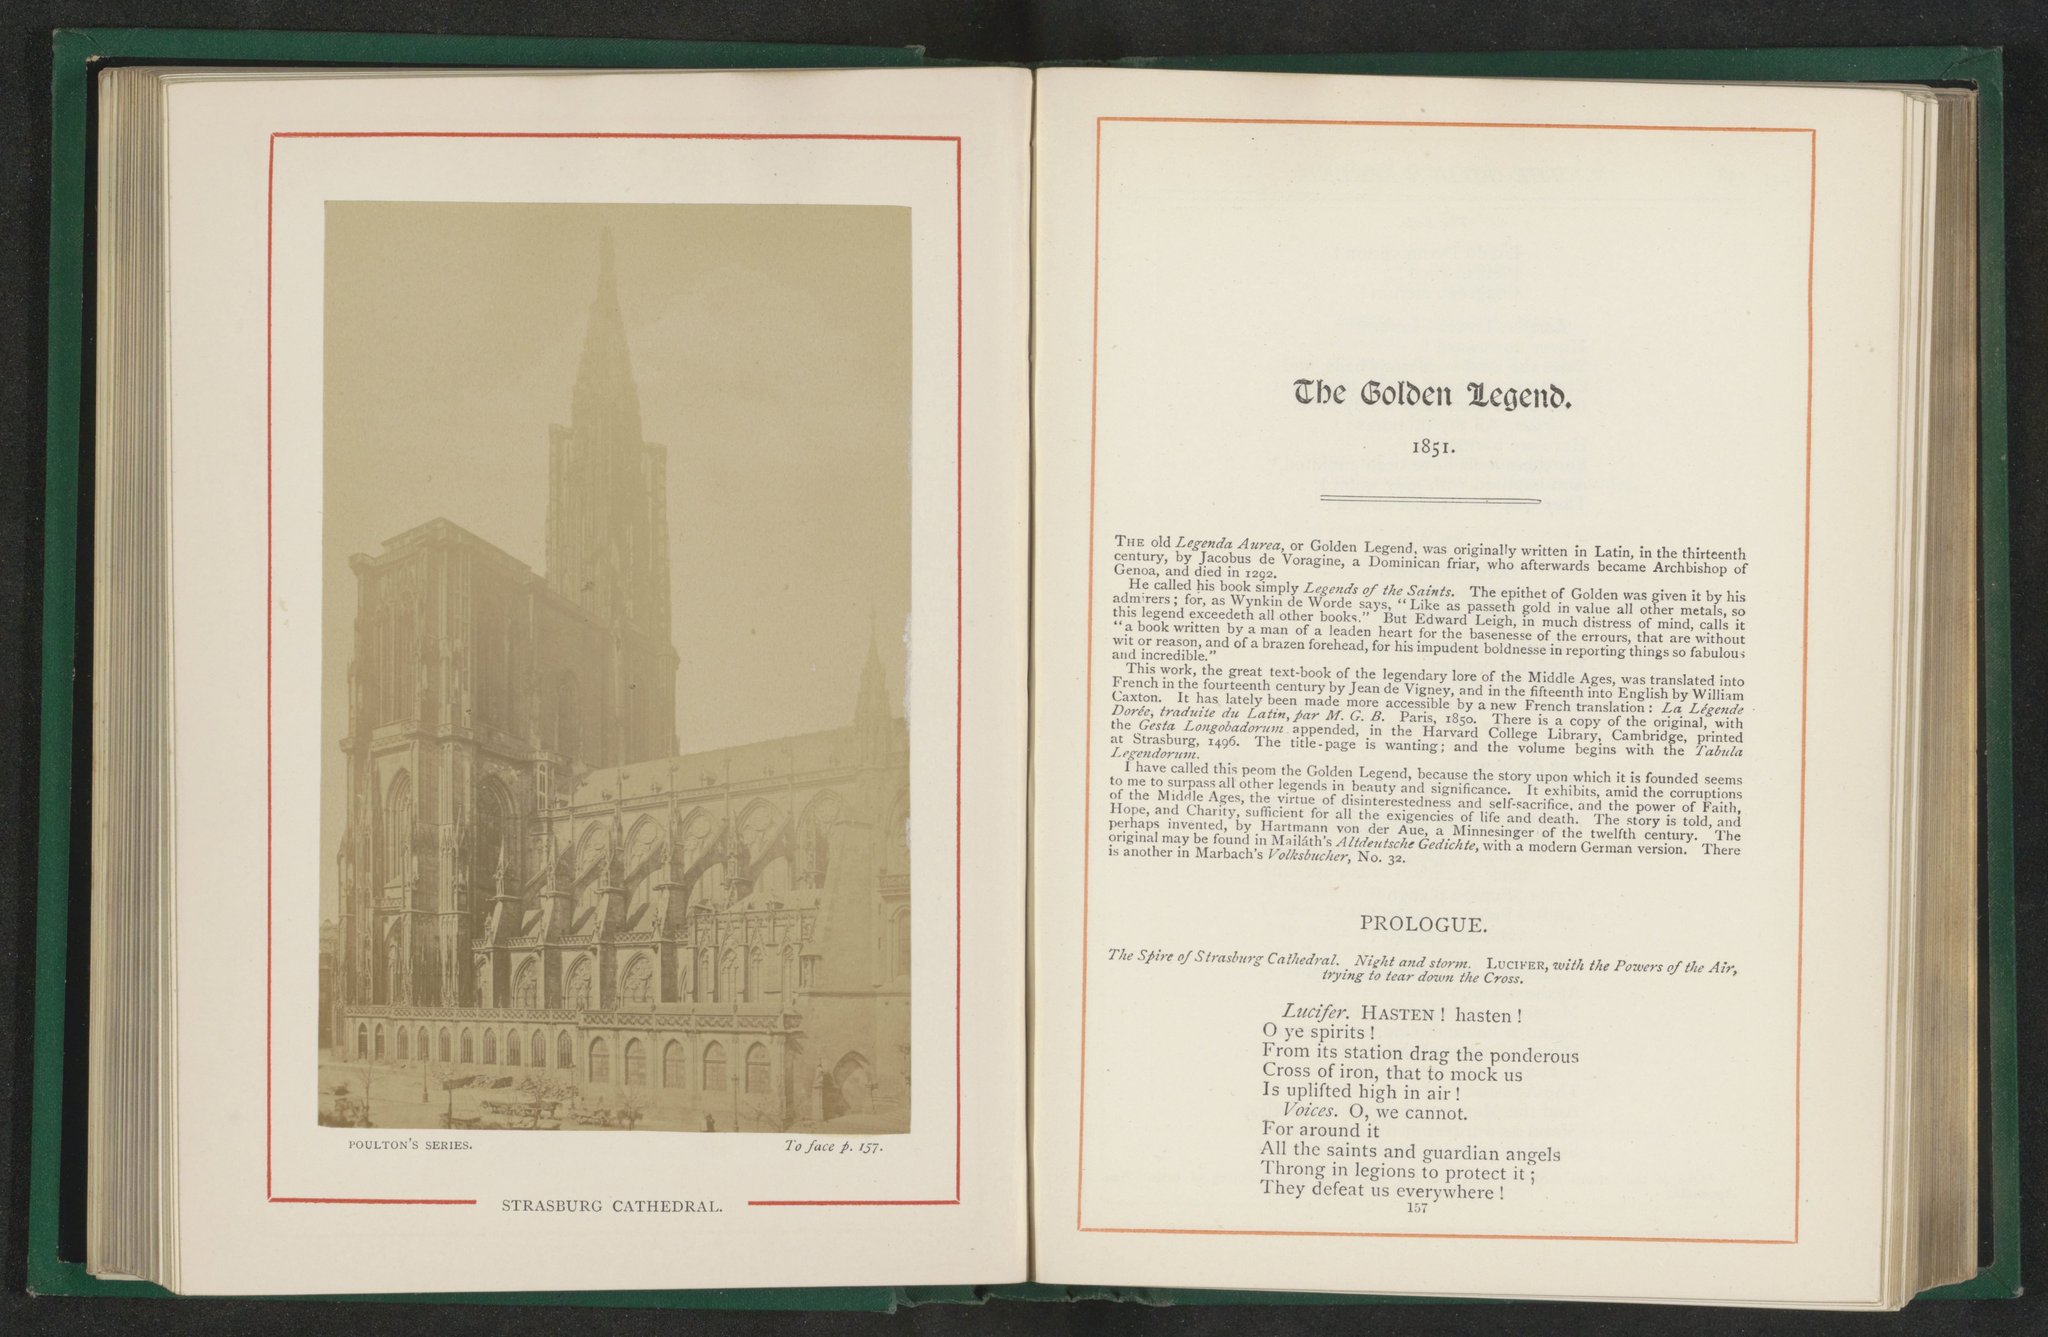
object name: page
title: Gezicht op de kathedraal de Notre-Dame in Straatsburg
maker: Anonymous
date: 1879-1889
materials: photographic support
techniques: albumen print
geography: straatsburg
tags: church (exterior), parts of church exterior and annexes: tower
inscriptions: inscription: ‘Poulton's Series.’